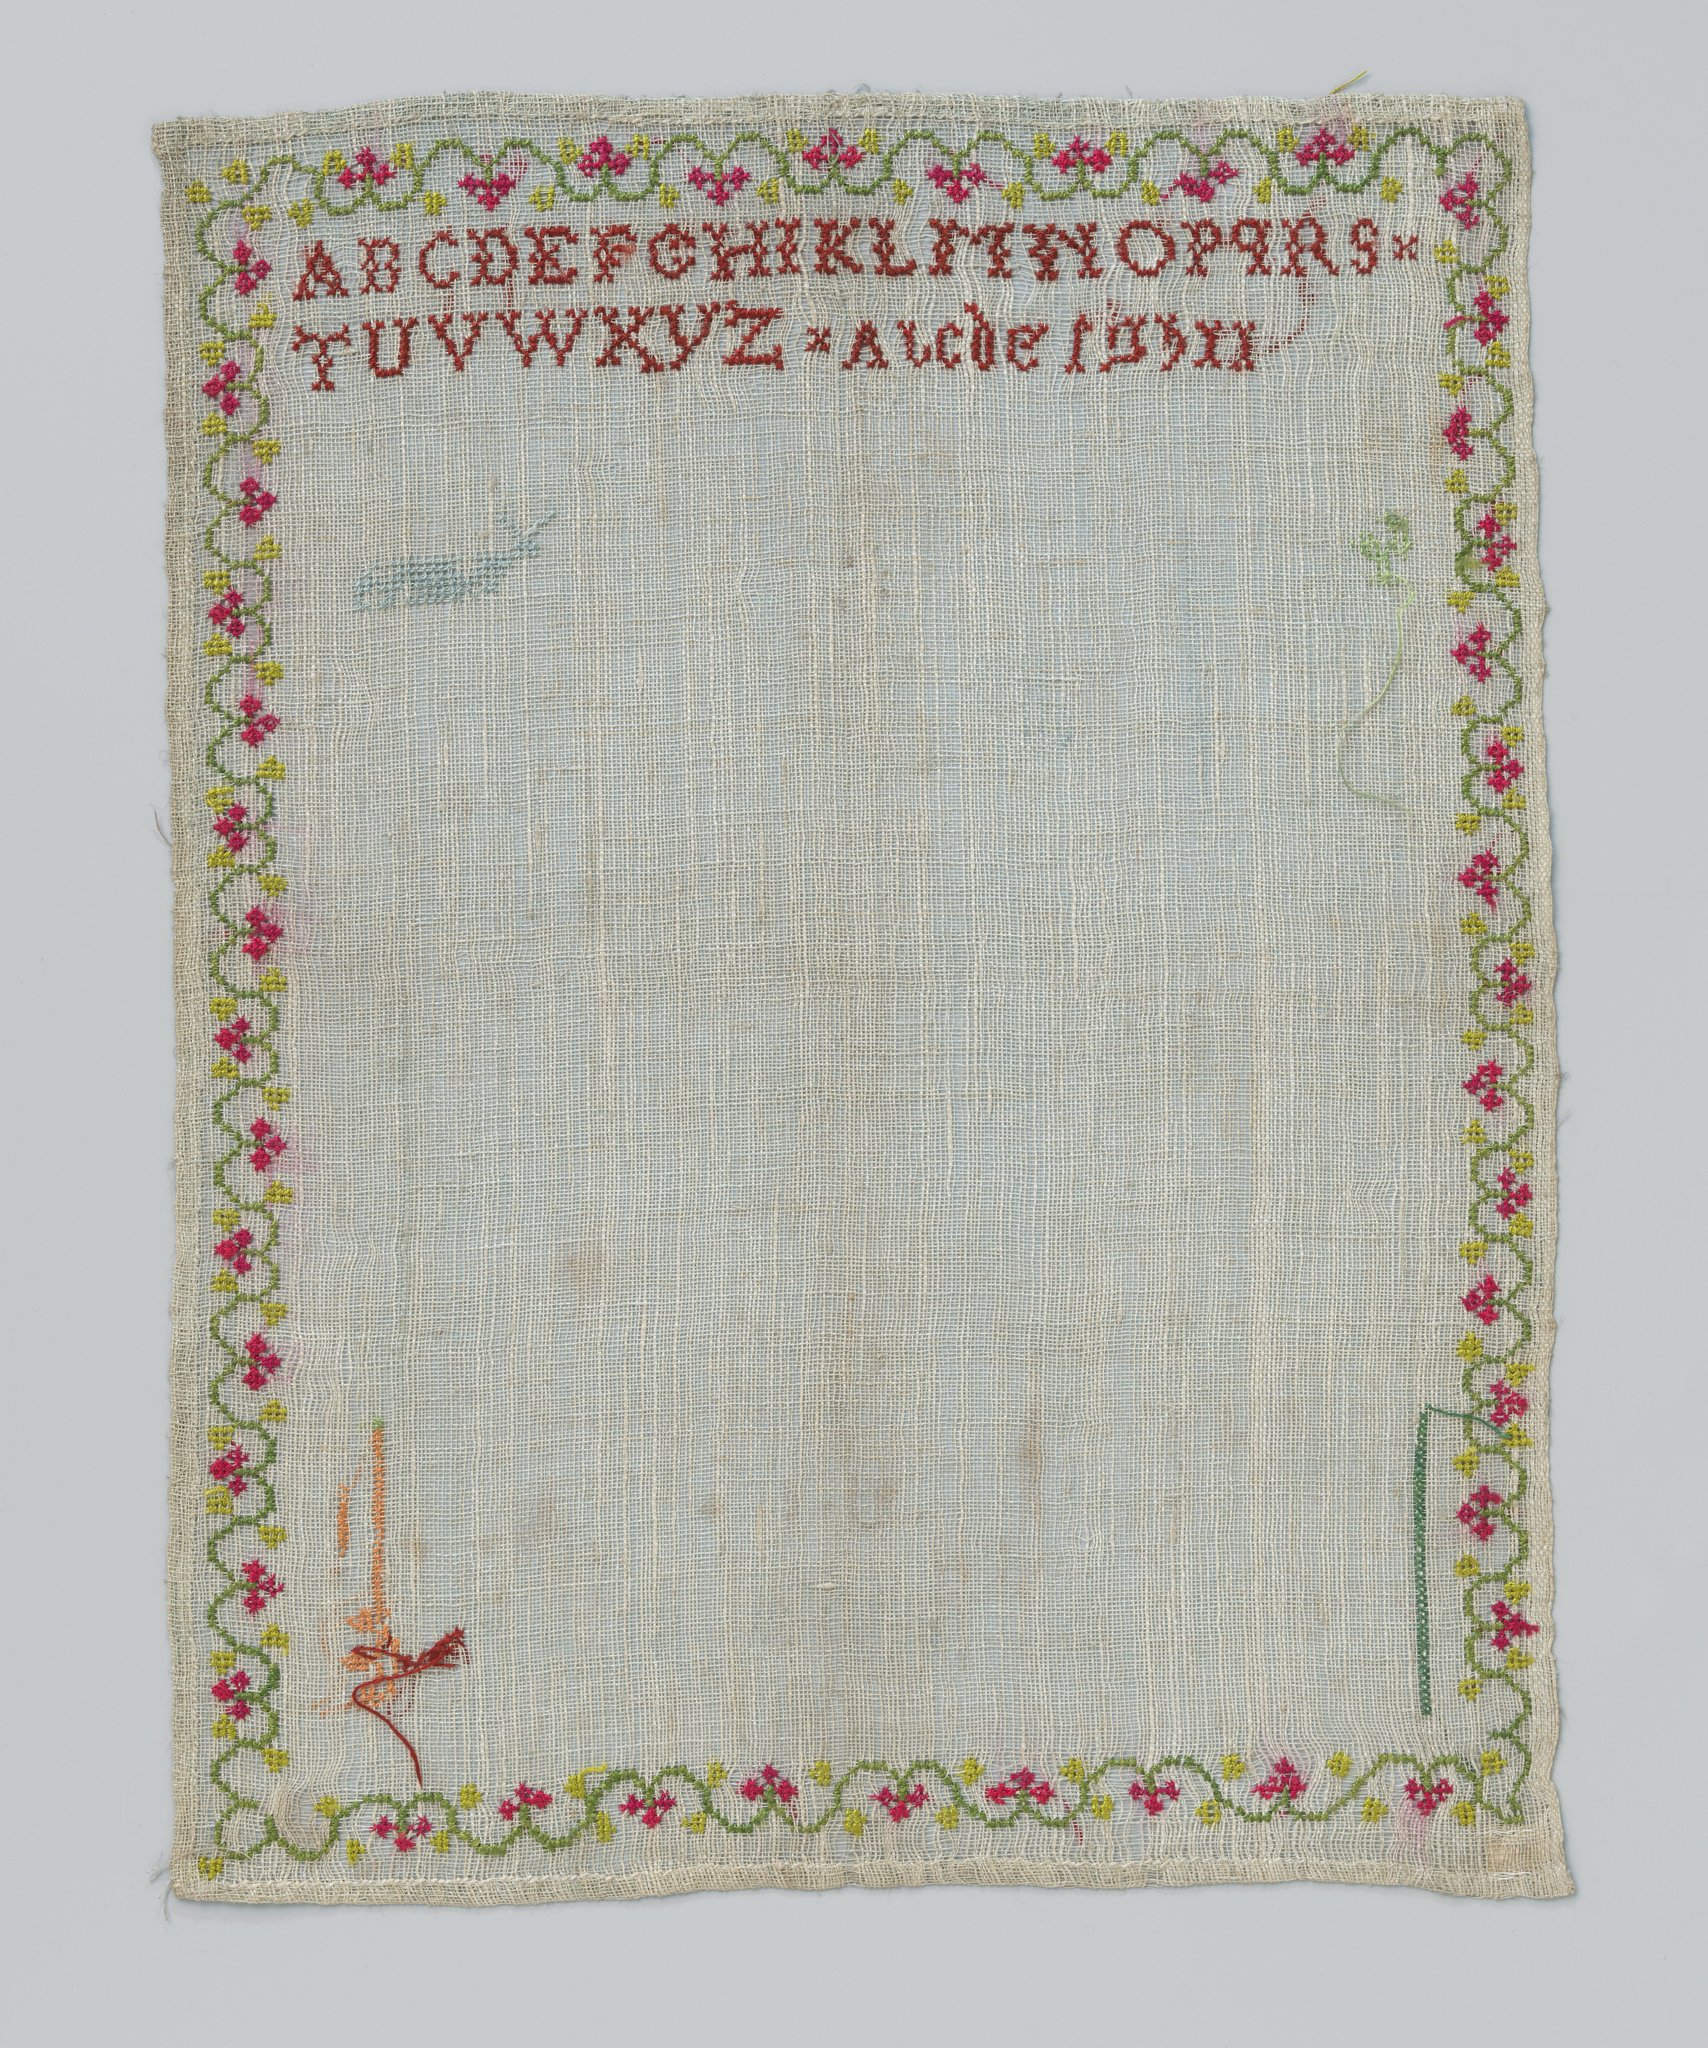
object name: merkdoek, merklap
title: Merklap van linnen. De merklap maakt deel uit van negen merklappen van verschillende grootten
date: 1750-1800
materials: linen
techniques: embroidered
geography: south holland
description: Merklap van linnen. De merklap maakt deel uit van negen merklappen van verschillende grootten (BK-NM-10759-A t/m BK-NM-10759-I).